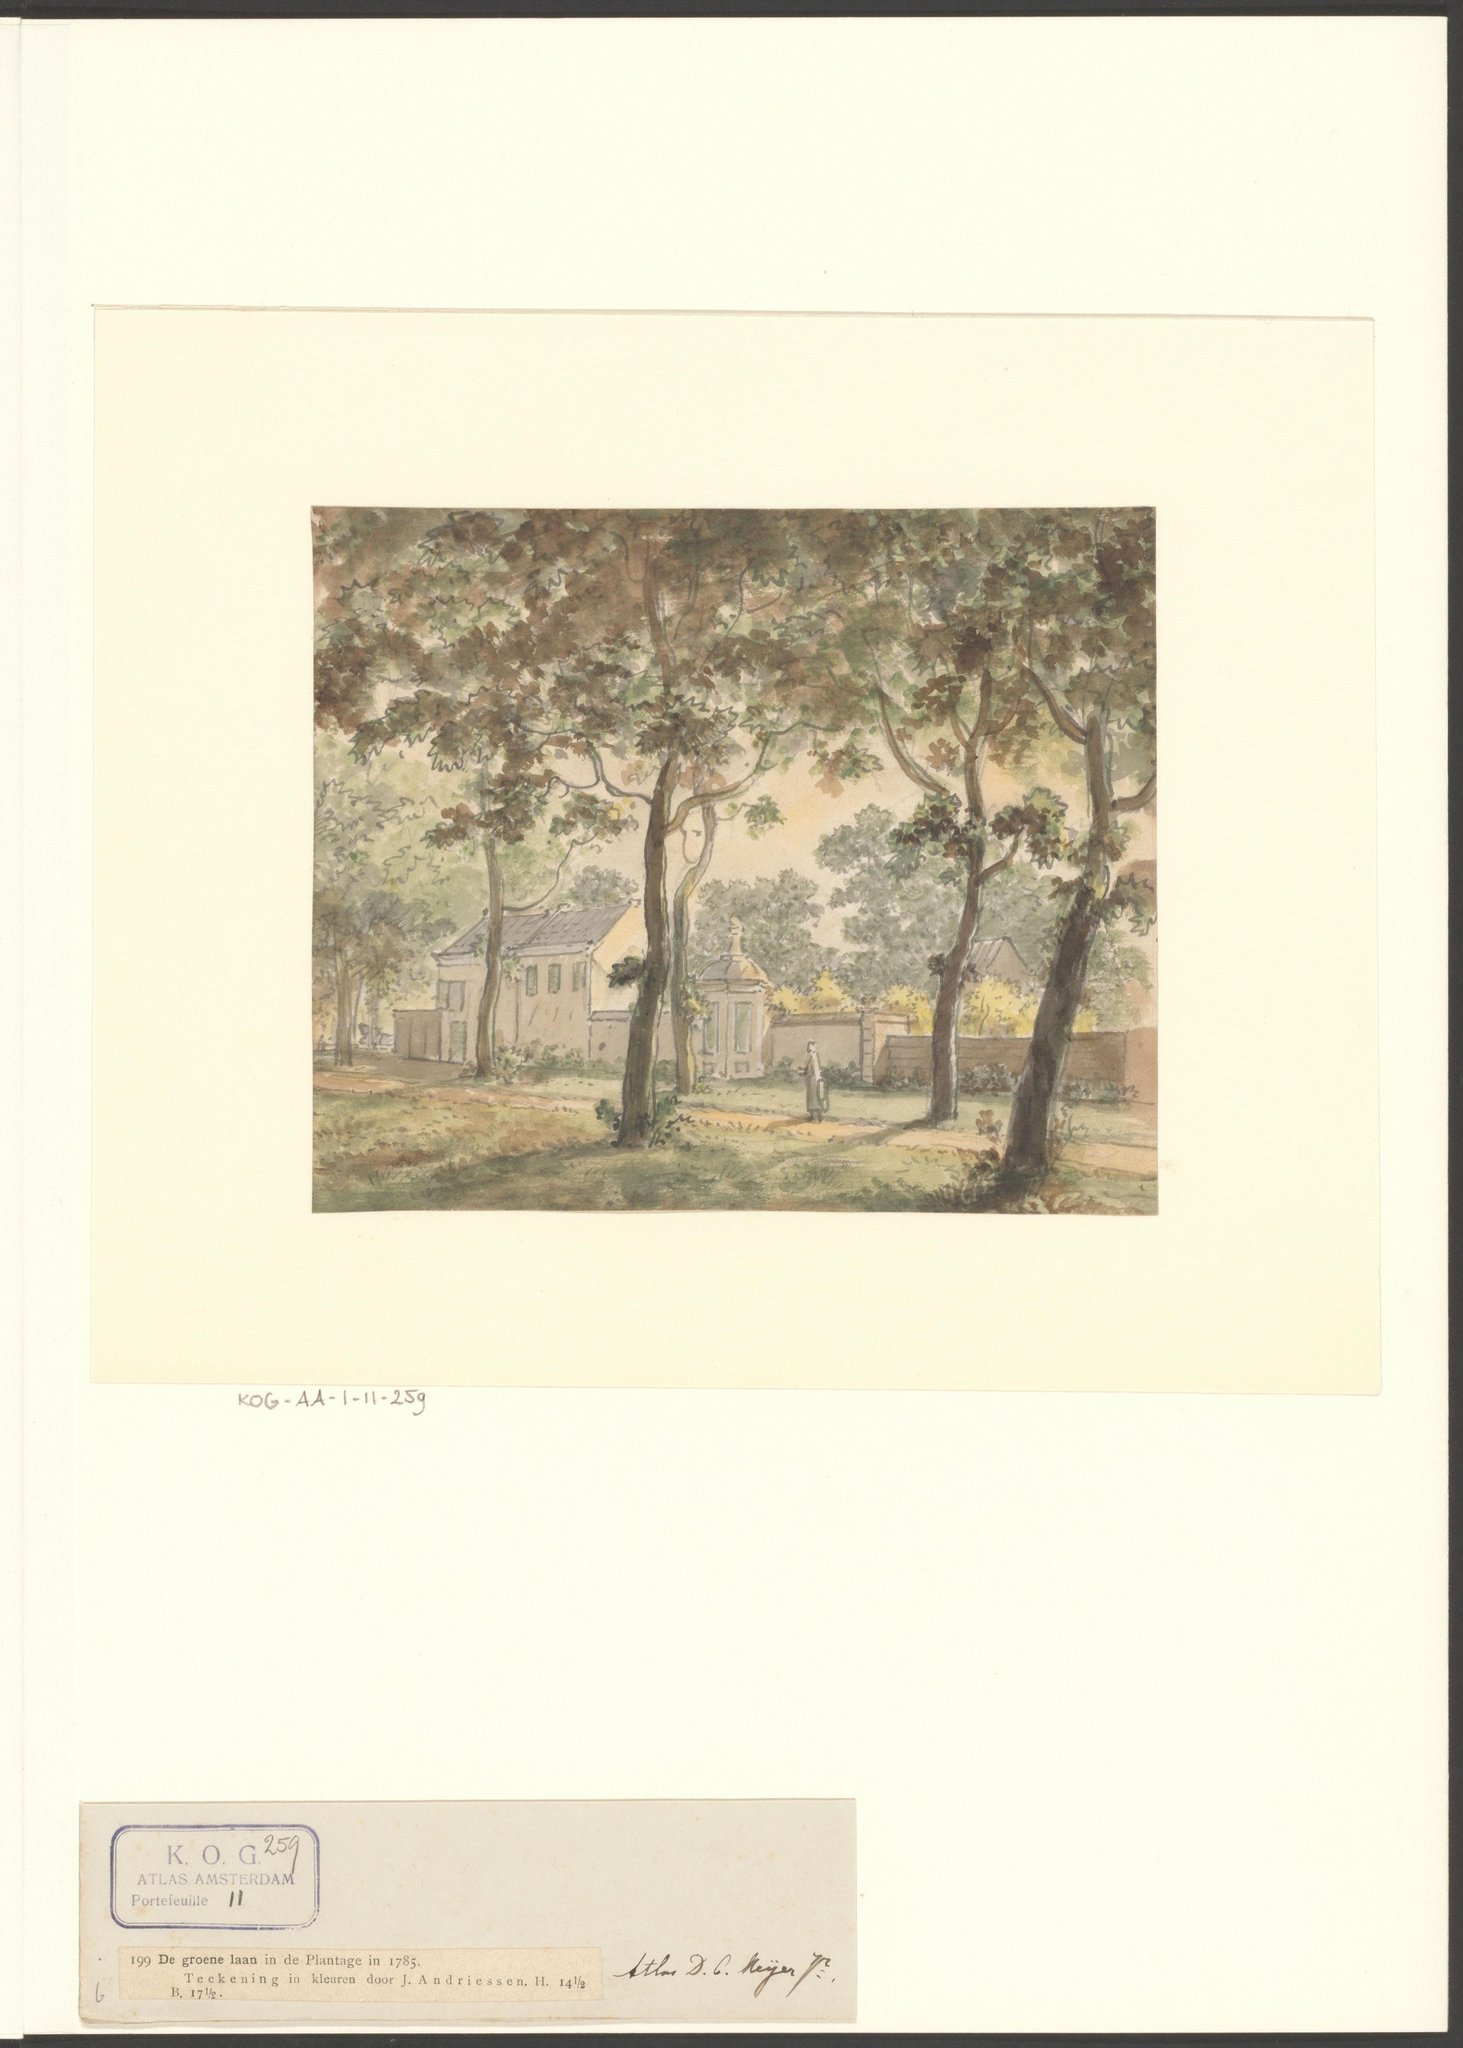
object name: drawing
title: Gezicht in de Plantage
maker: jurriaan andriessen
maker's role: draughtsman, painter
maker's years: 1742-1819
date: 1785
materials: ink, paper, pencil, watercolor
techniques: brush, pen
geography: amsterdam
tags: city-view in general; 'veduta', road, path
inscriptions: inscription: ‘de groene laan inde Plantage 1785’, inscription: ‘Port. 11-259’, collector's mark: ‘11’ Lugt 1641b, inscription: ‘199 De groene (...) D.C. Meijer Jr.’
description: Onderwerpsrubriek binnen de Atlas Amsterdam: Paleisstraat, Palmgracht, Papenbrugsteeg, Passeerdersgracht, Peperstraat, Pieterspoort (St.), Pieterssteeg (St.), Plantage, Prinseneiland.